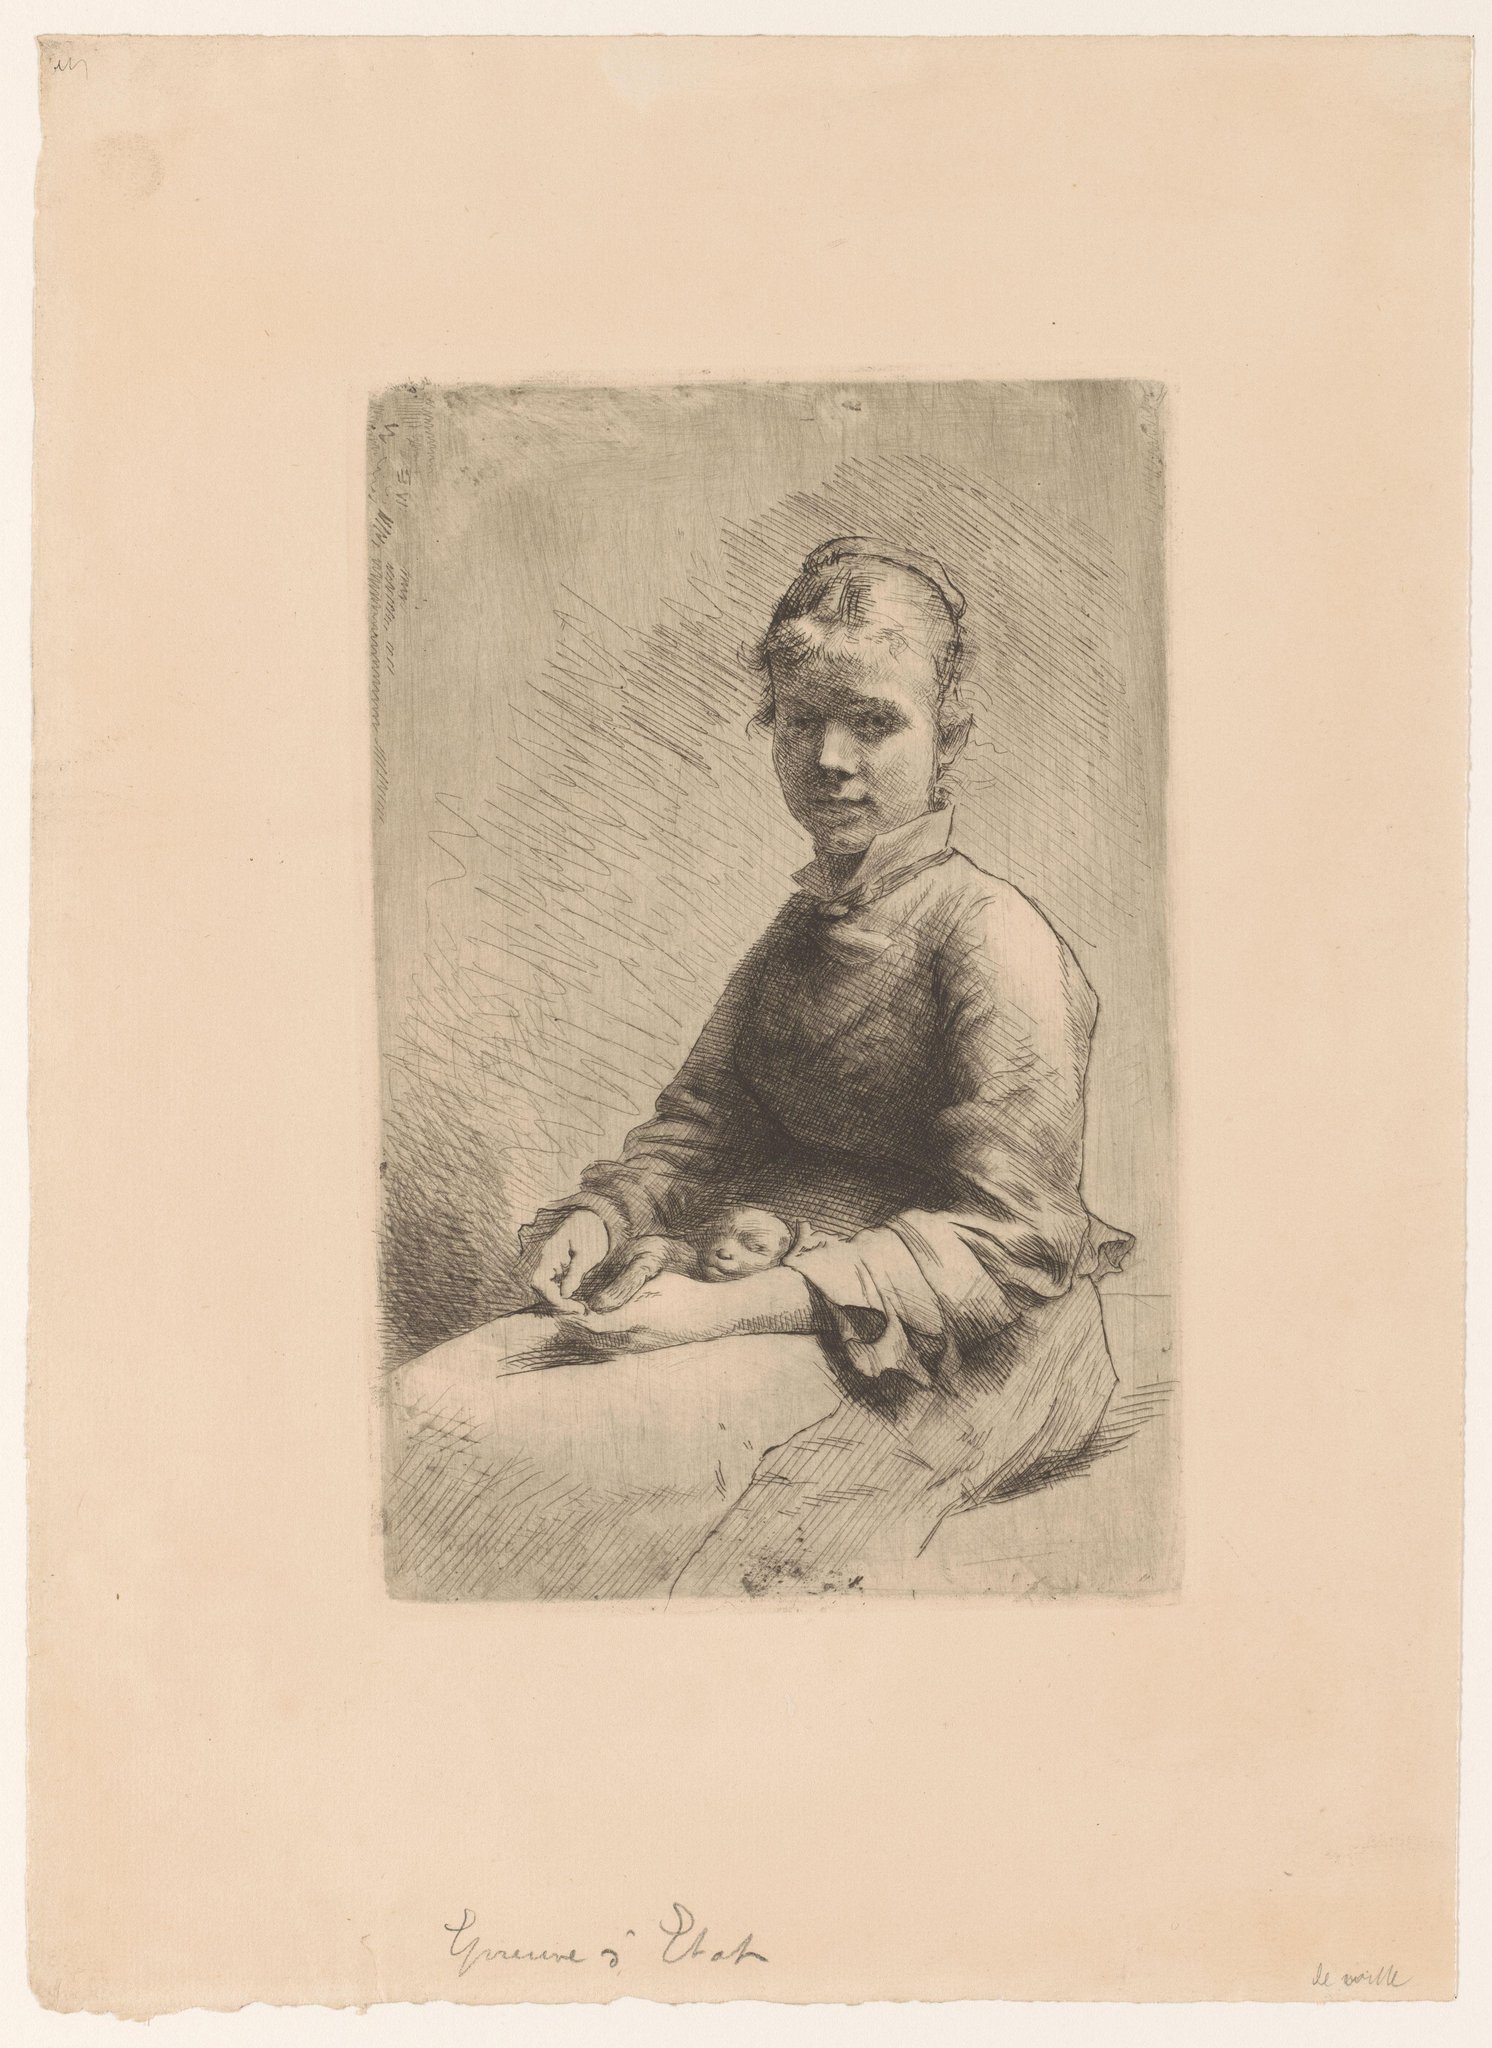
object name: print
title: Portret van een onbekende jonge vrouw met hond op schoot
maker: adrien de witte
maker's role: print maker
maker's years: 1850-1935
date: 1877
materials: paper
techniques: etching, intaglio, retroussage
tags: adolescent, young woman, maiden, sitting figure - aa - female human figure, historical persons, dog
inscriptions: collector's mark: Lugt 2228, inscription: ‘Epreuve d'Etat’